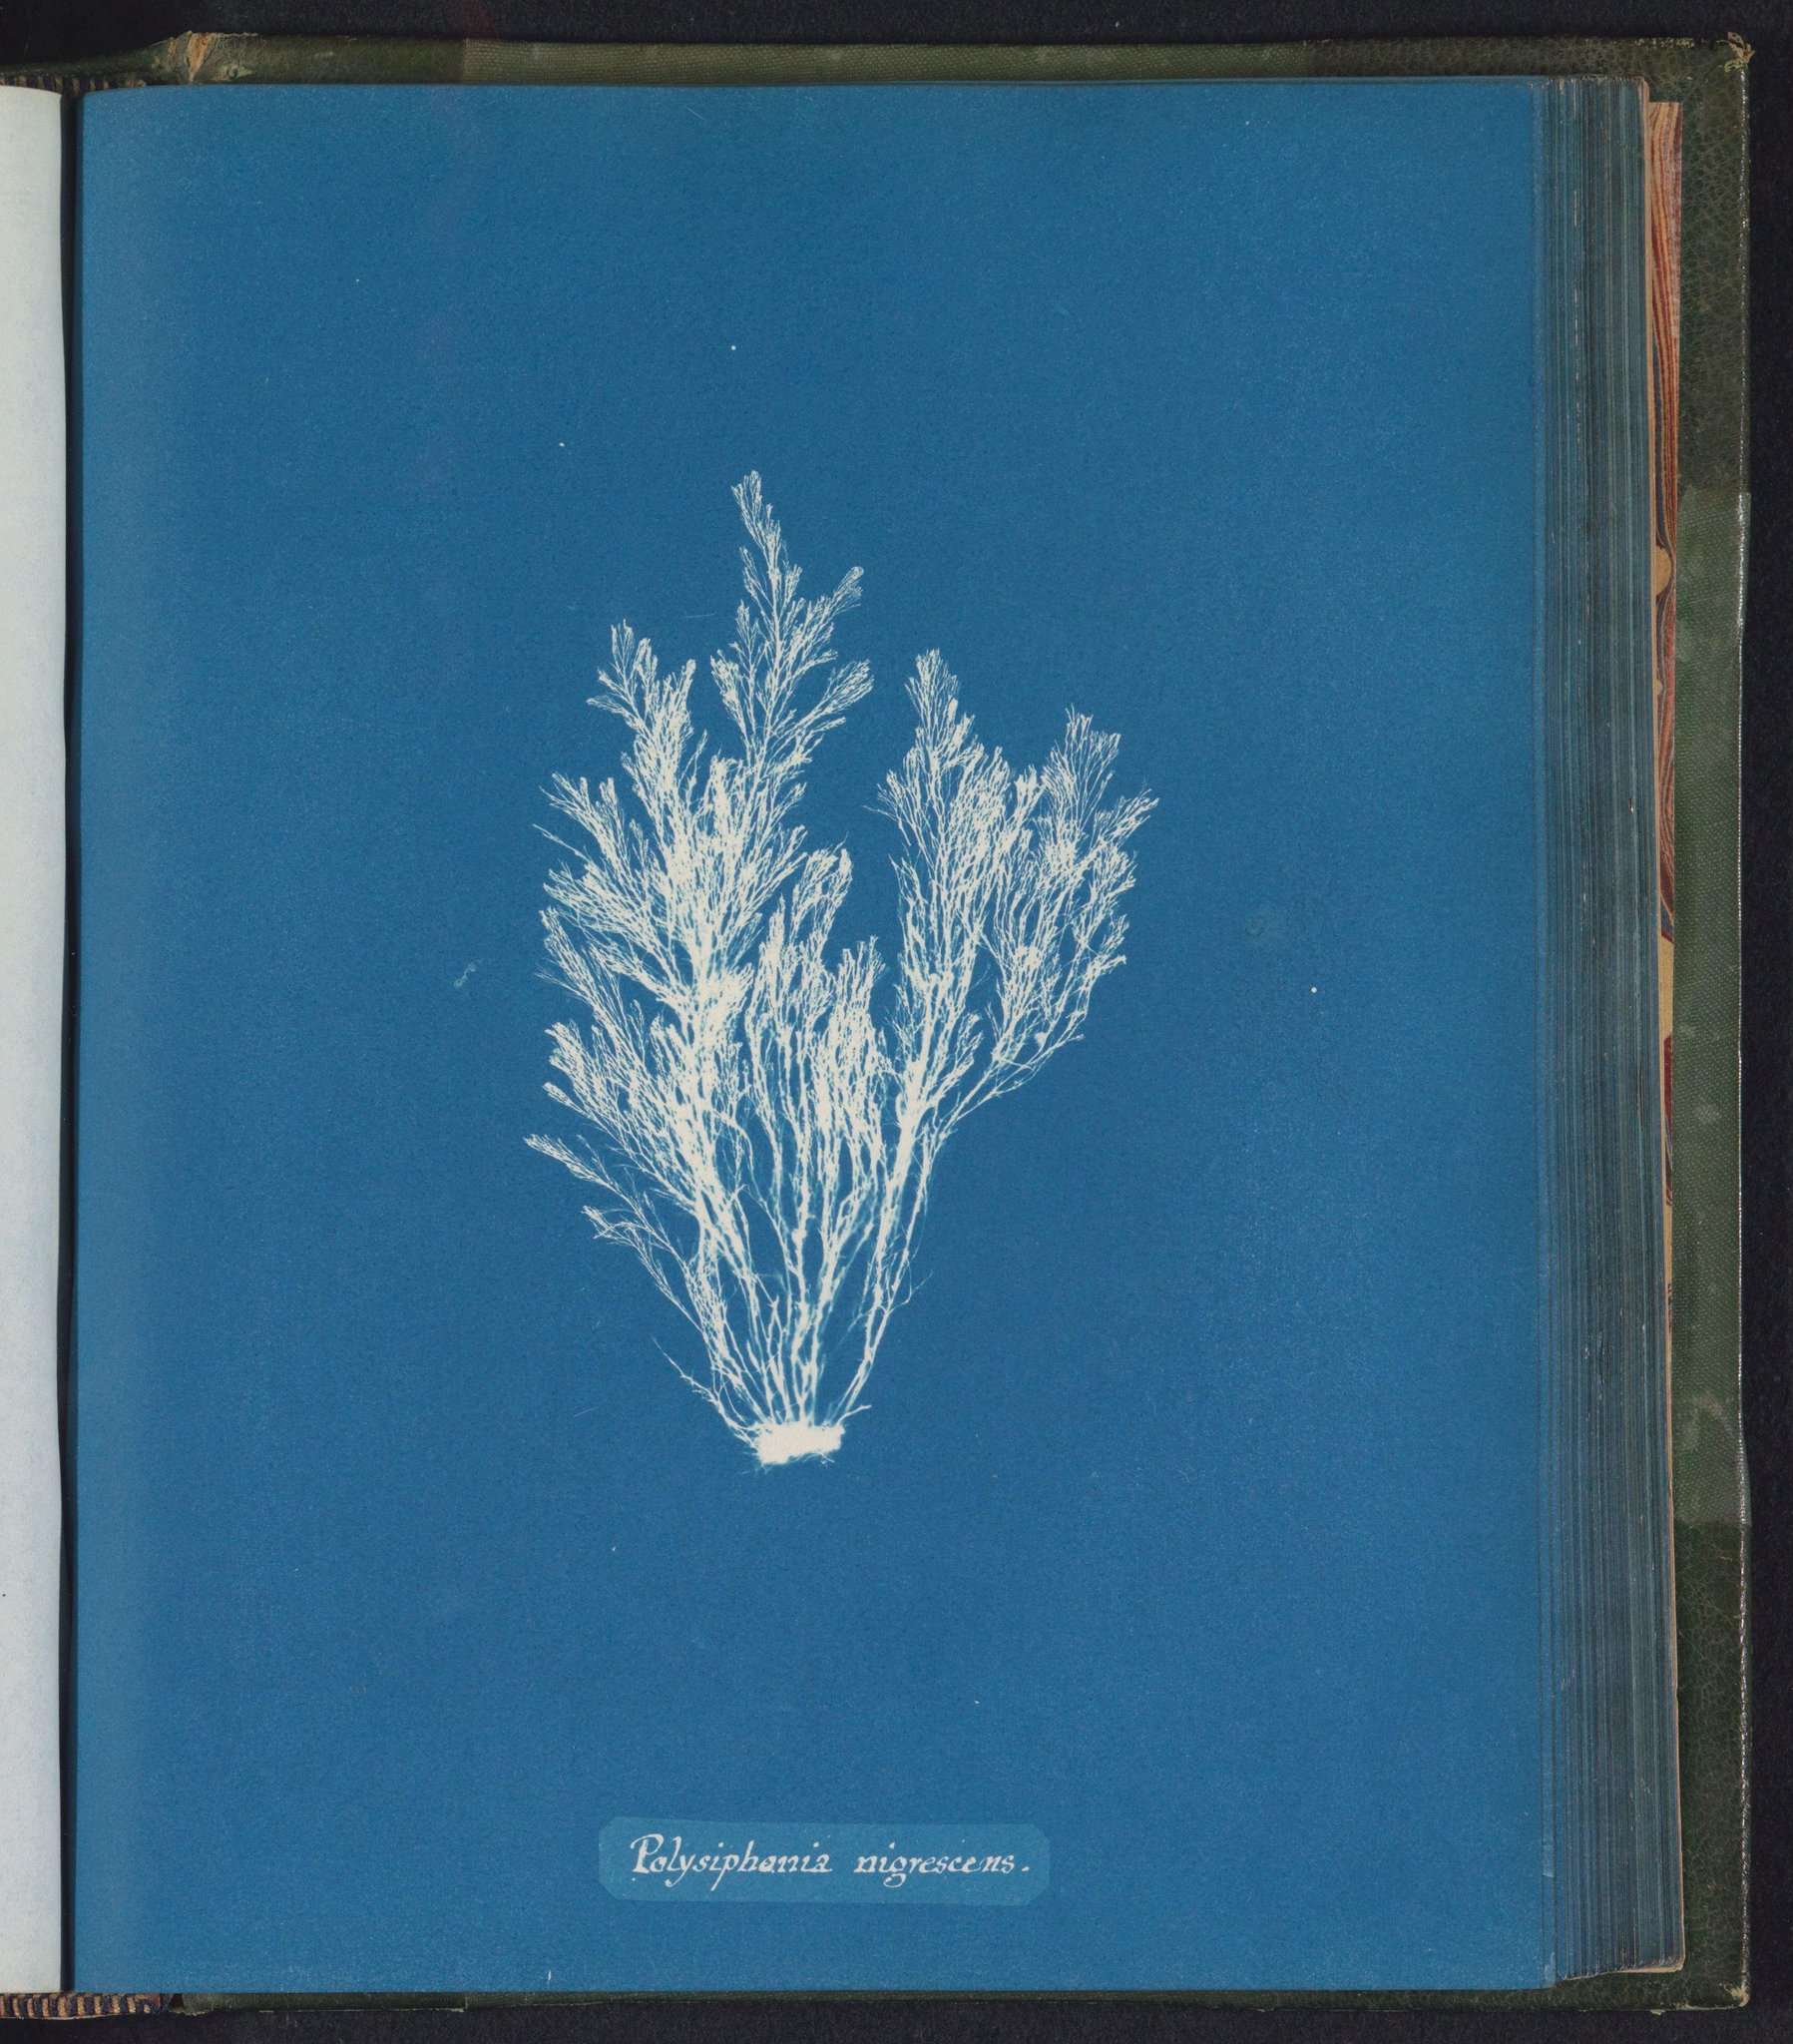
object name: page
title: Zeewier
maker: anna atkins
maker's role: fotograaf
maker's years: 1799-1871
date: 1843-1853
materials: photographic support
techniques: cyanotype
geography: united kingdom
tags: algae, seaweed